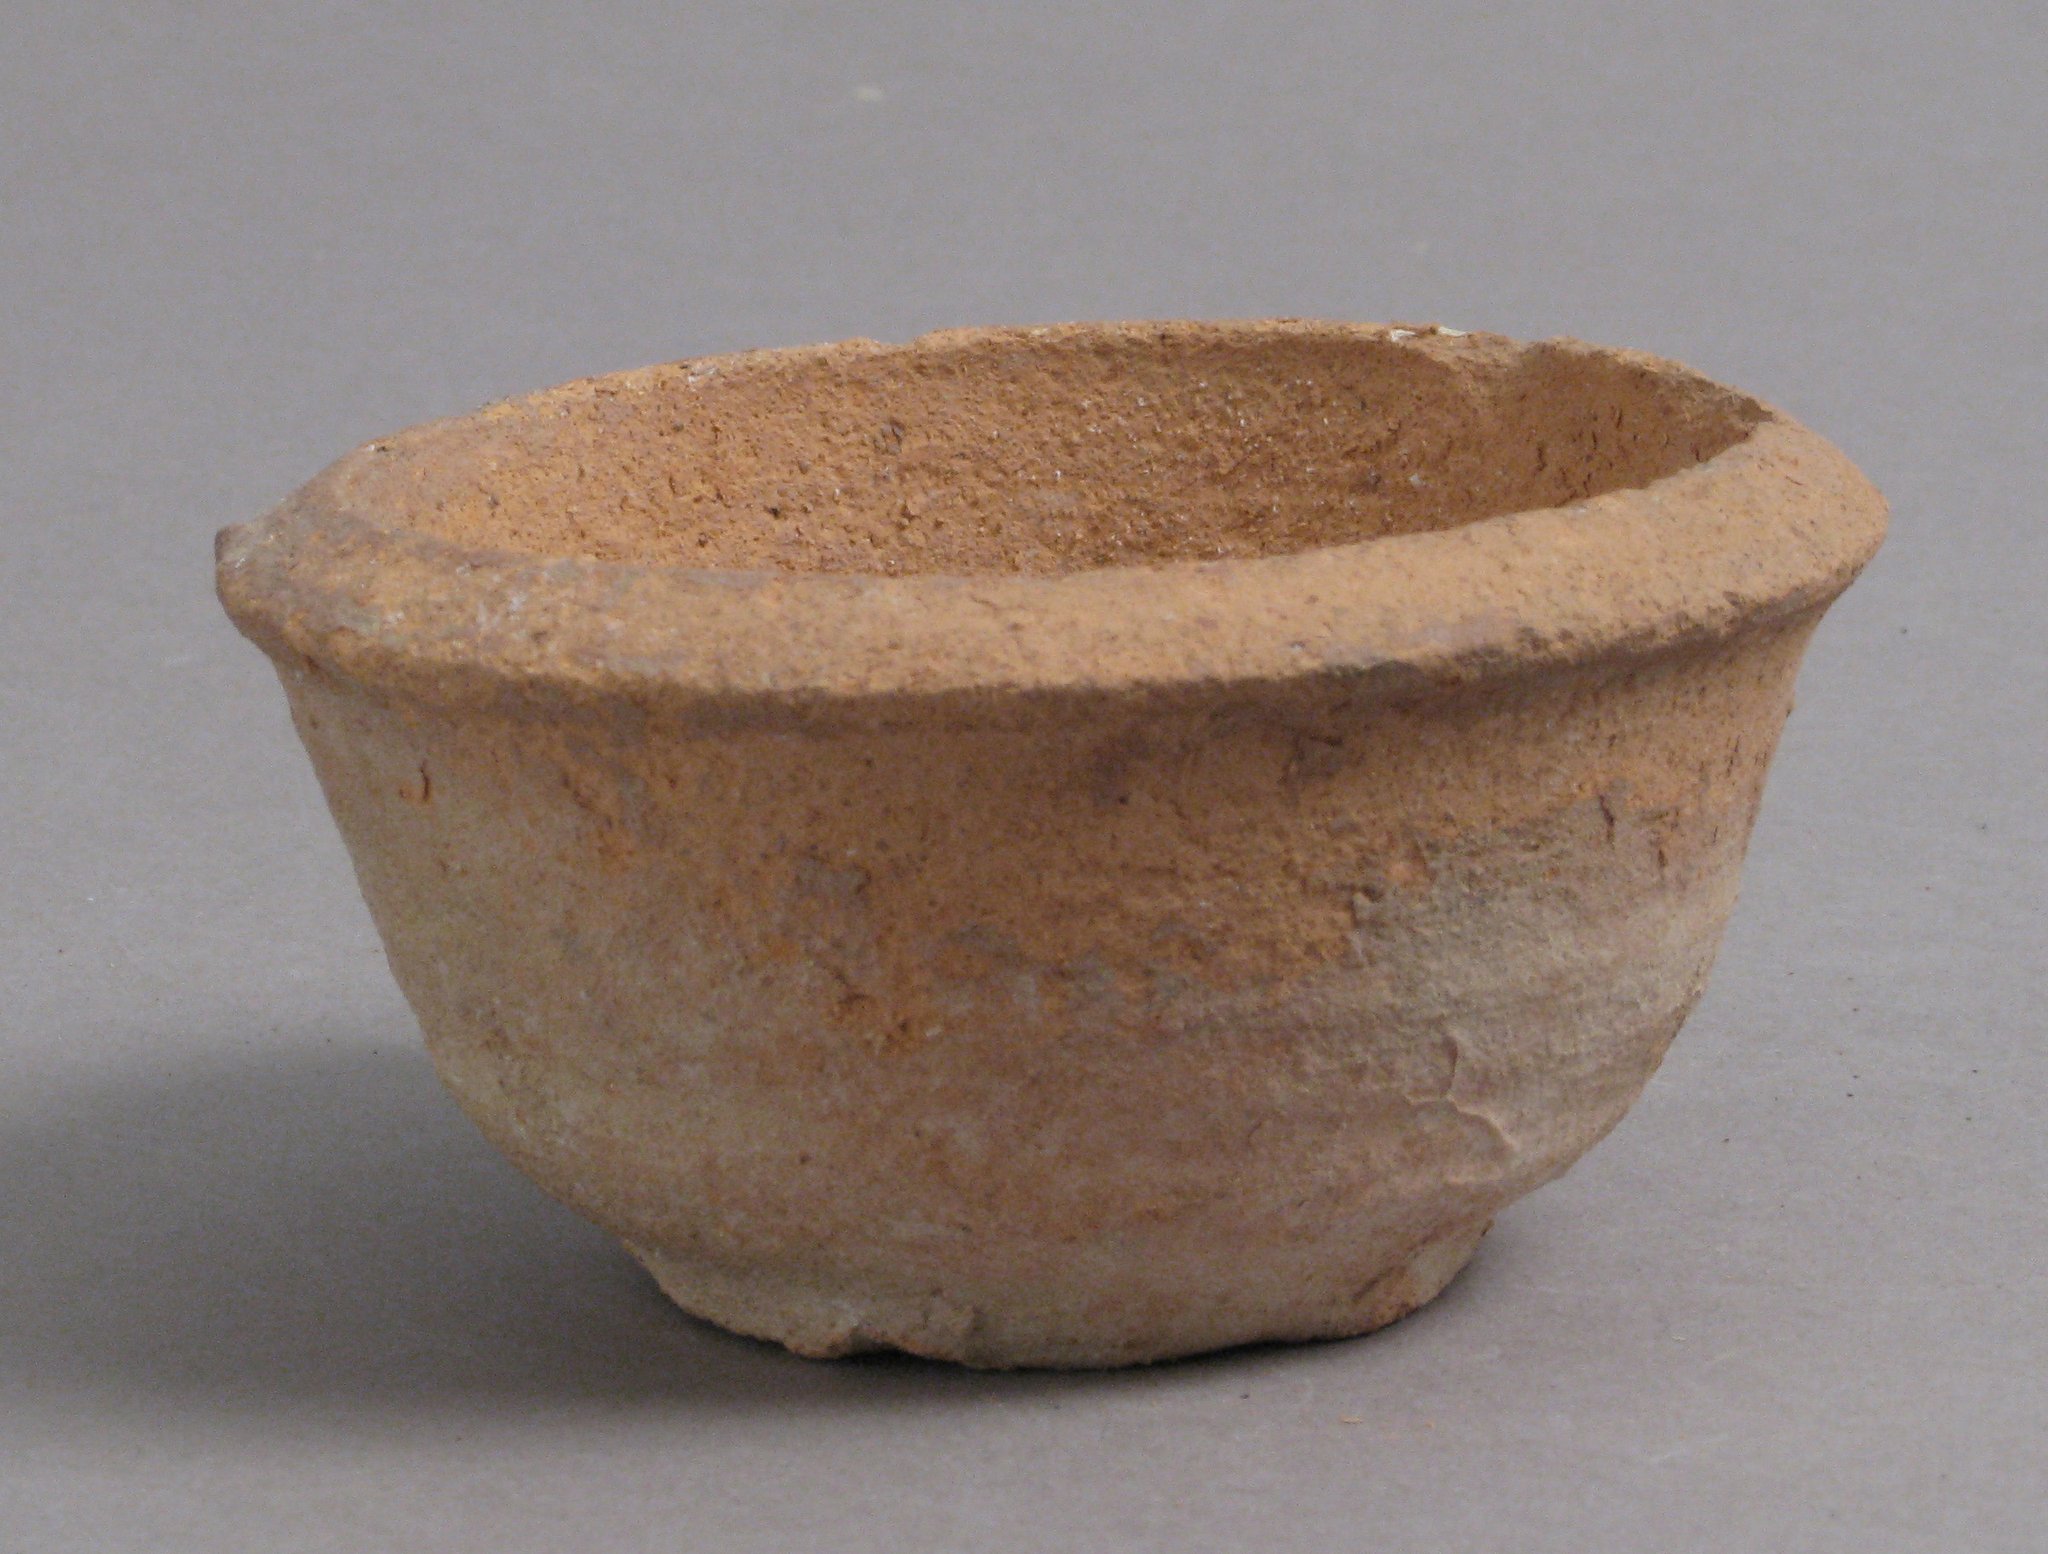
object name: bowl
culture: coptic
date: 301-700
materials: earthenware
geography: egypt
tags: bowls